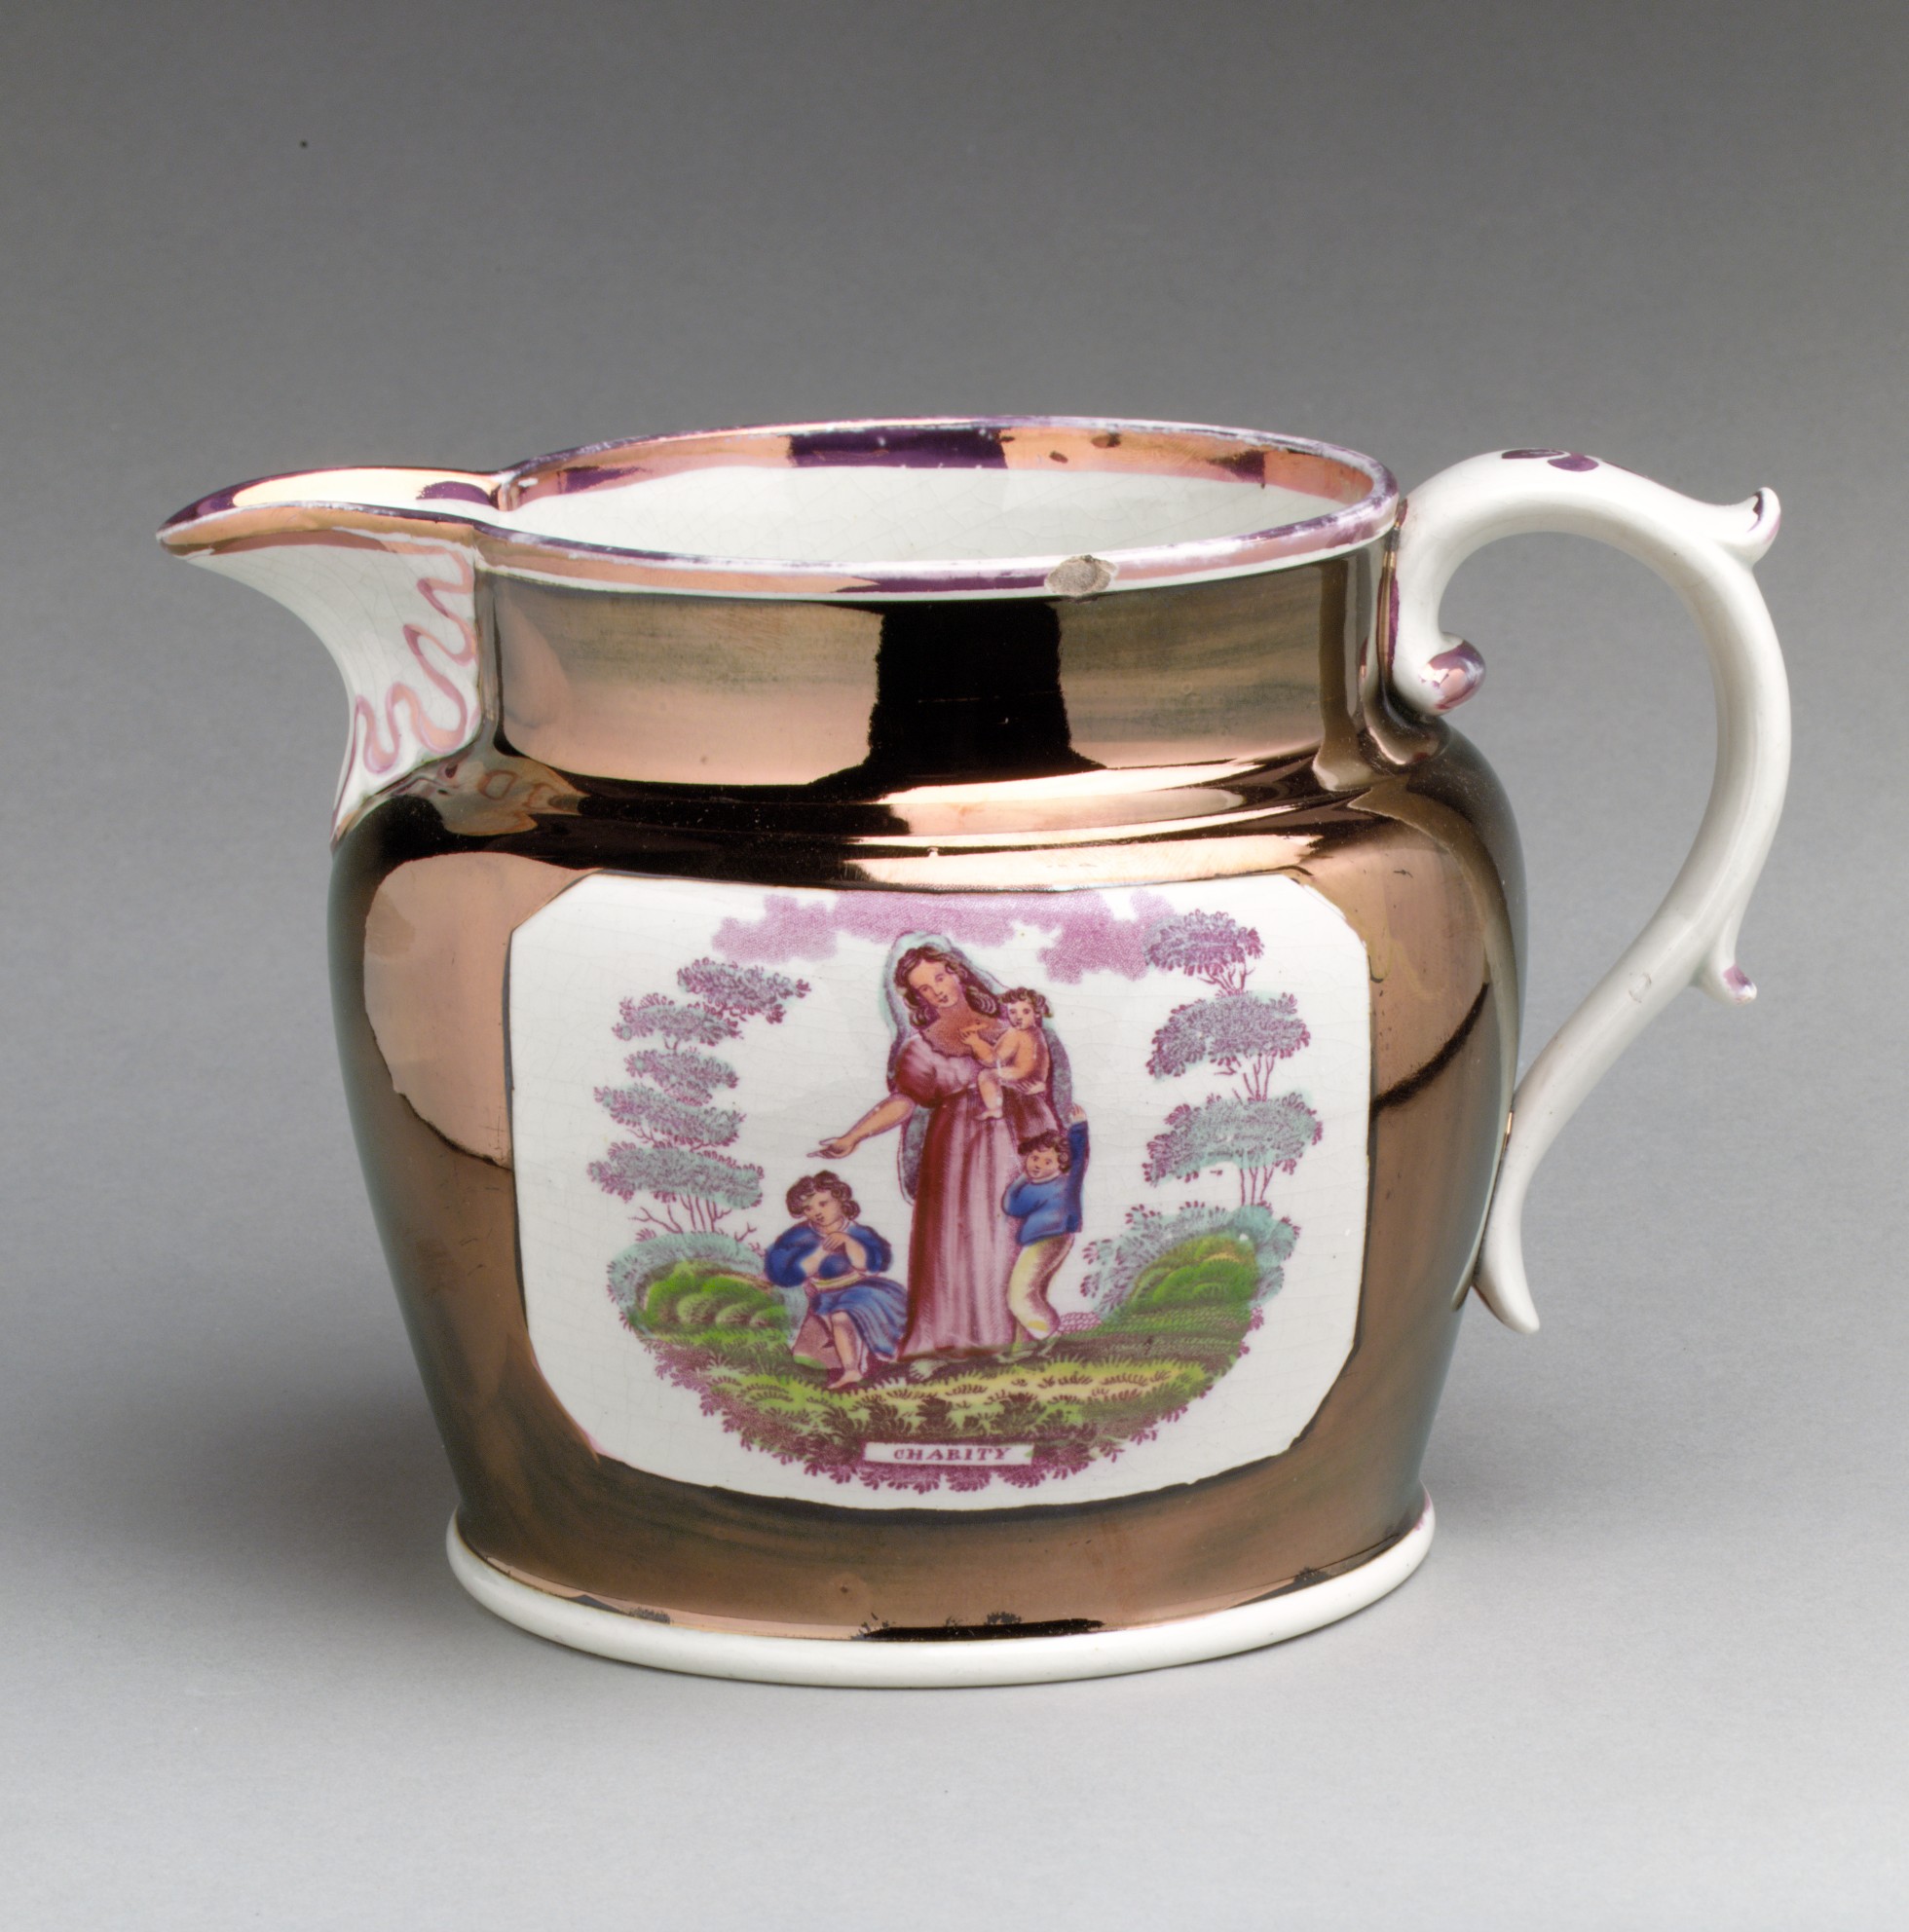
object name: pitcher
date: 1801-1900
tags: boys,girls,infants,women